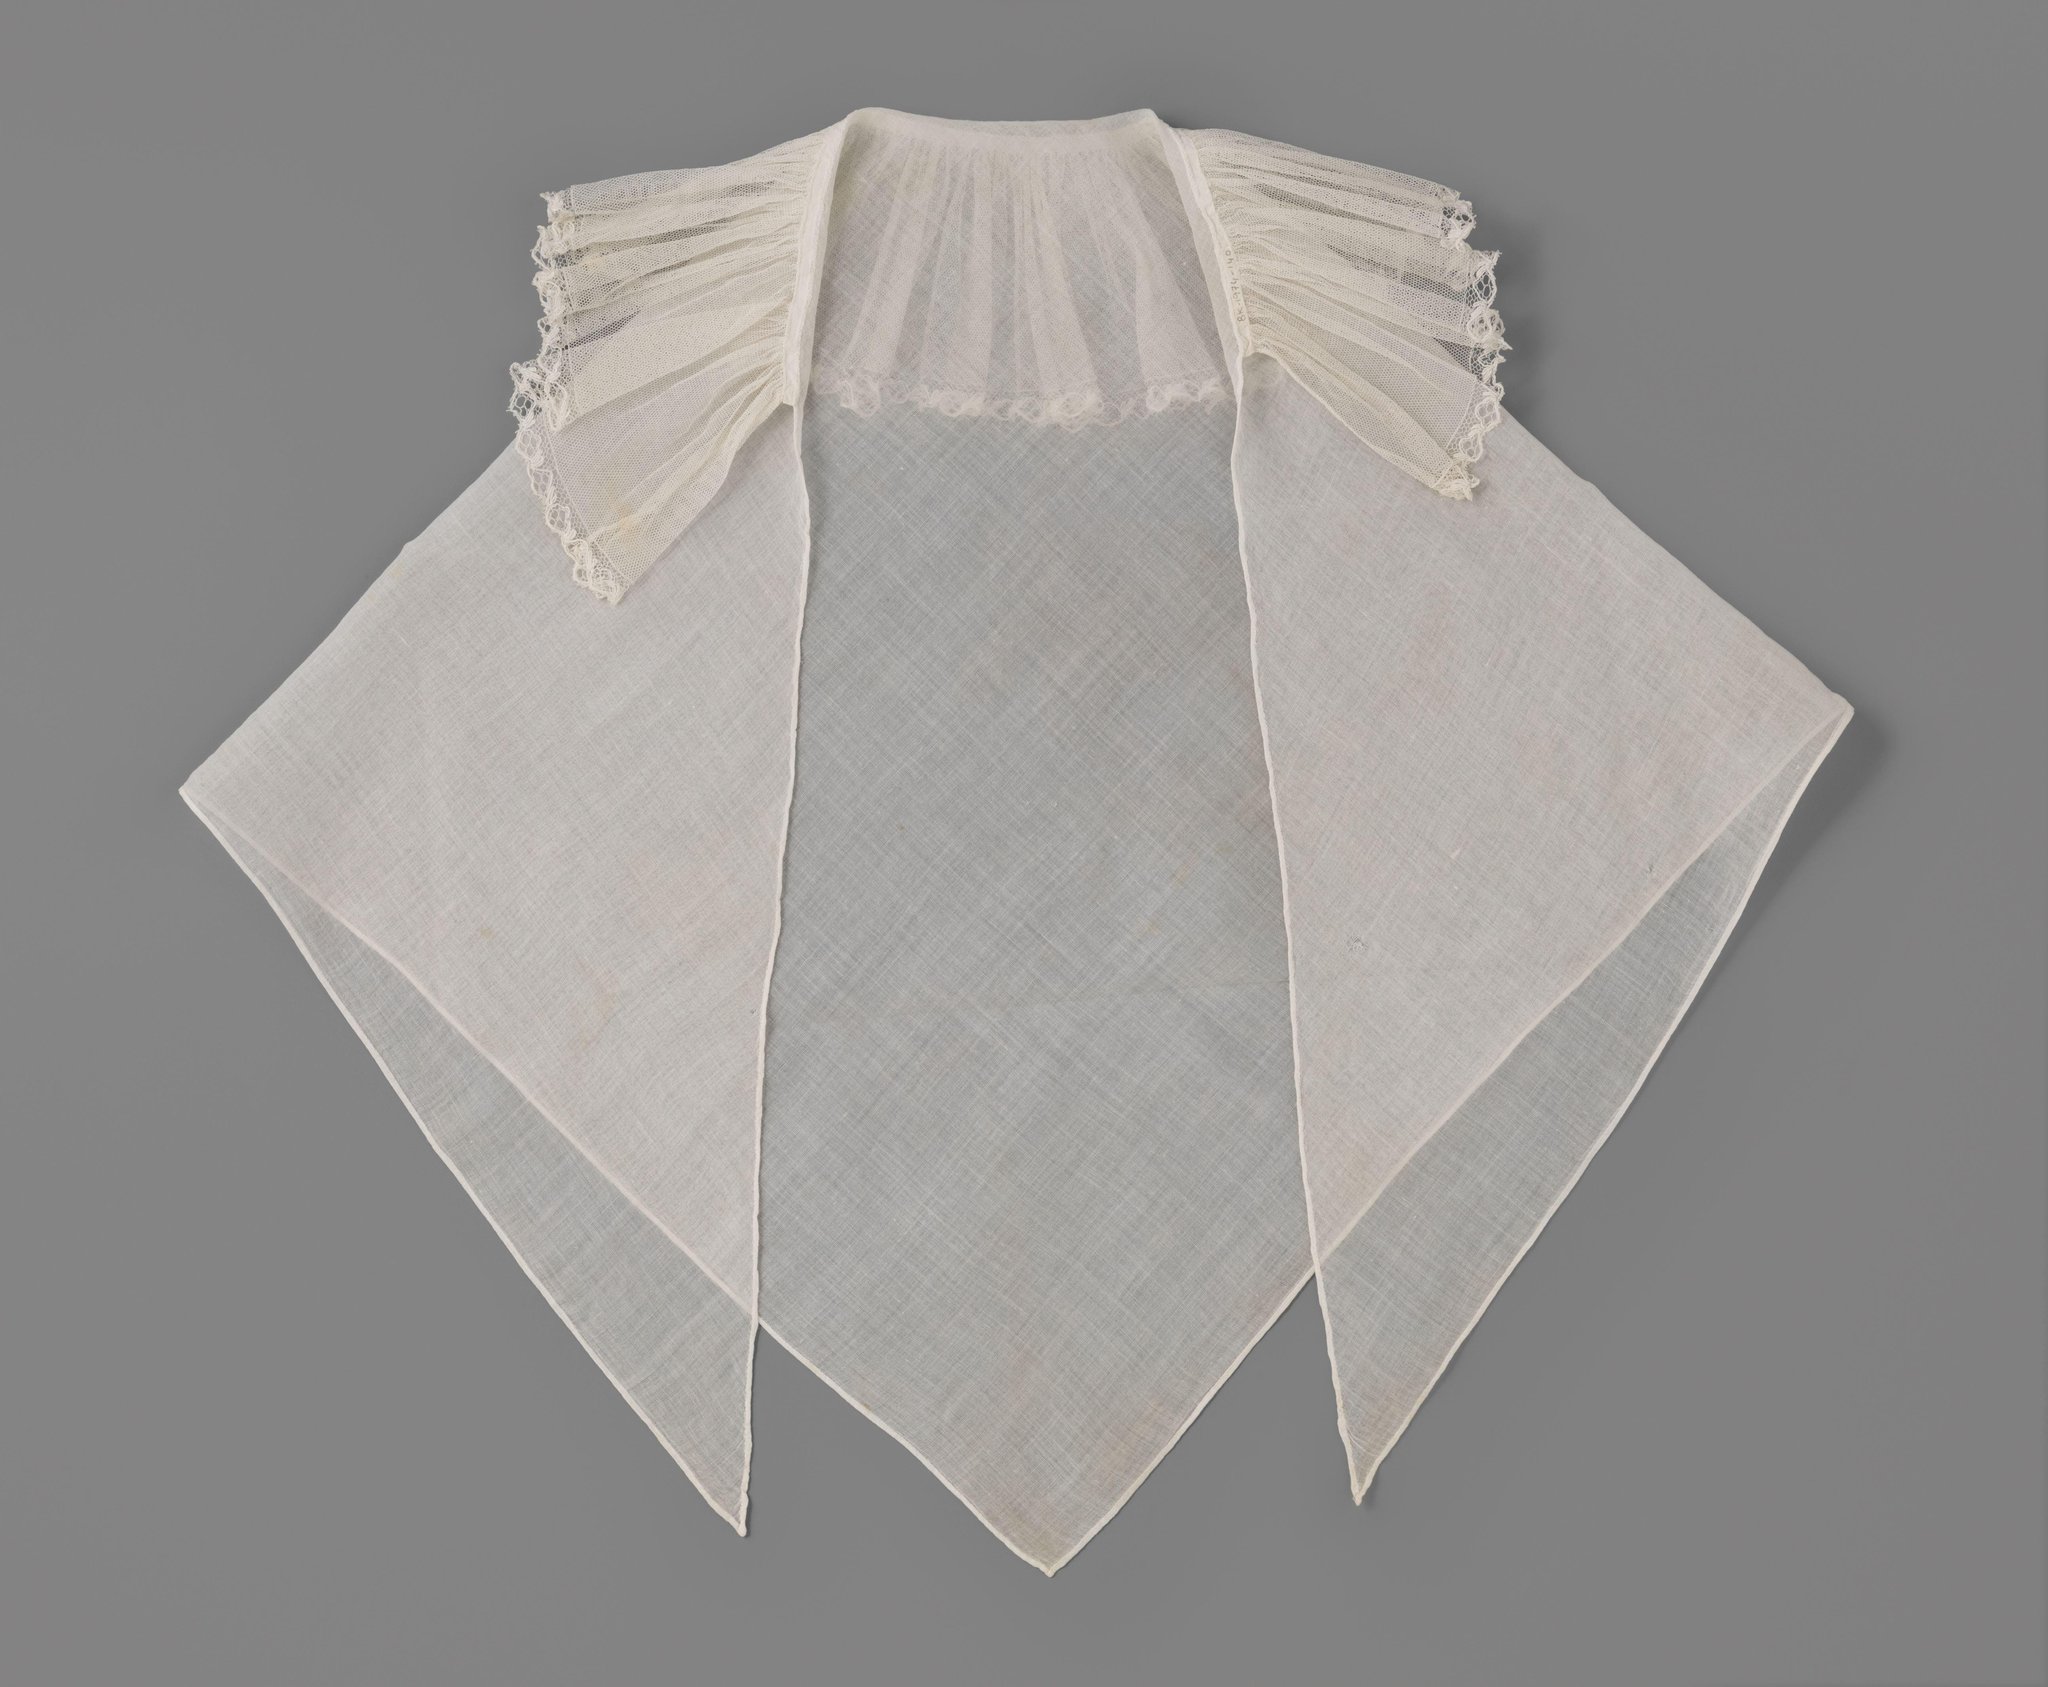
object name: womenswear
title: Fichu van katoenen kaasdoek, driehoekig, met aangezette, gerimpelde strook van zijden tule afgezet met smalle strook kant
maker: Anonymous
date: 1820-1825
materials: cotton, linen, silk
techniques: cockled, weave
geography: netherlands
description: Fichu van katoenen kaasdoek, driehoekig, met aangezette, gerimpelde strook van zijden tule afgezet met smalle strook kant. Model: langs alle zijden smalle, platte zoom. Versiering: halverwege de rechte zijde is een small biaisband aangebracht, waaraan een strook tule is gerimpeld.